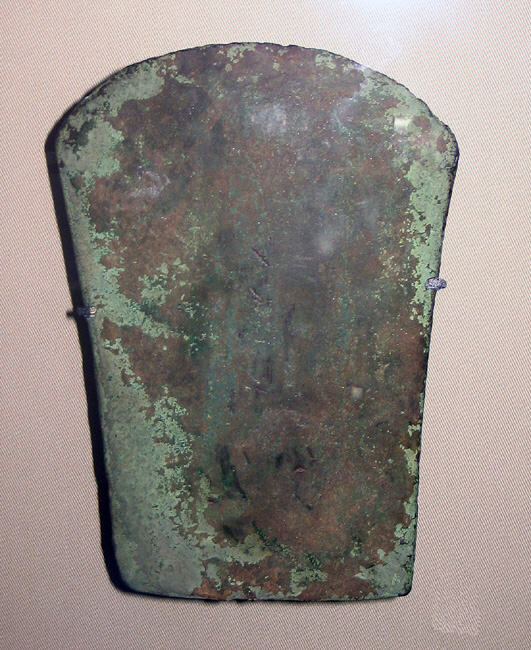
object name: ax blade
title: Ax Blade (Celt)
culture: indian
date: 1500-500 BCE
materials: copper